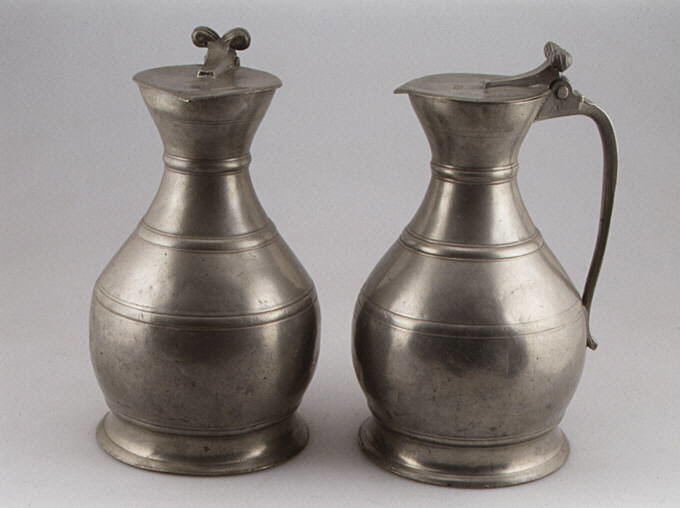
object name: flagon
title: Pair of flagons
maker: joseph samain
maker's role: maker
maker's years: 1736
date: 1765-1794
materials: pewter